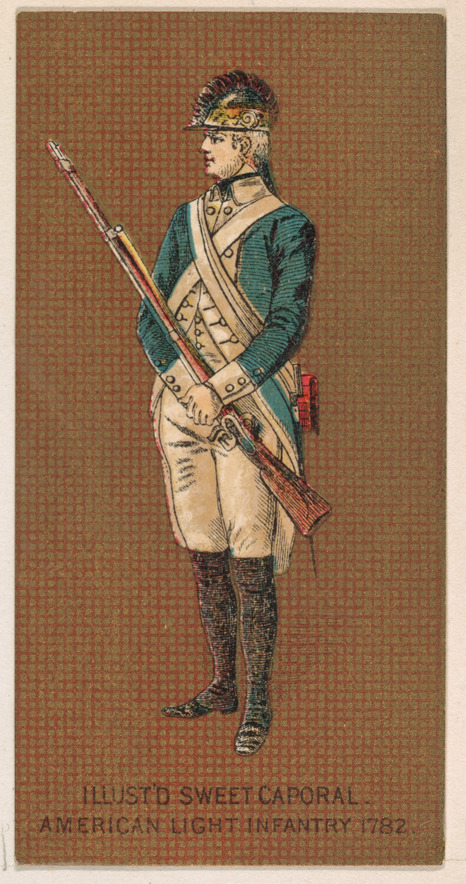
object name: print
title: American Light Infantry, 1782, from the Military Series (N224) issued by Kinney Tobacco Company to promote Sweet Caporal Cigarettes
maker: kinney brothers tobacco company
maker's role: publisher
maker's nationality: american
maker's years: 1869-2011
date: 1888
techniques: color lithograph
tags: soldiers,men